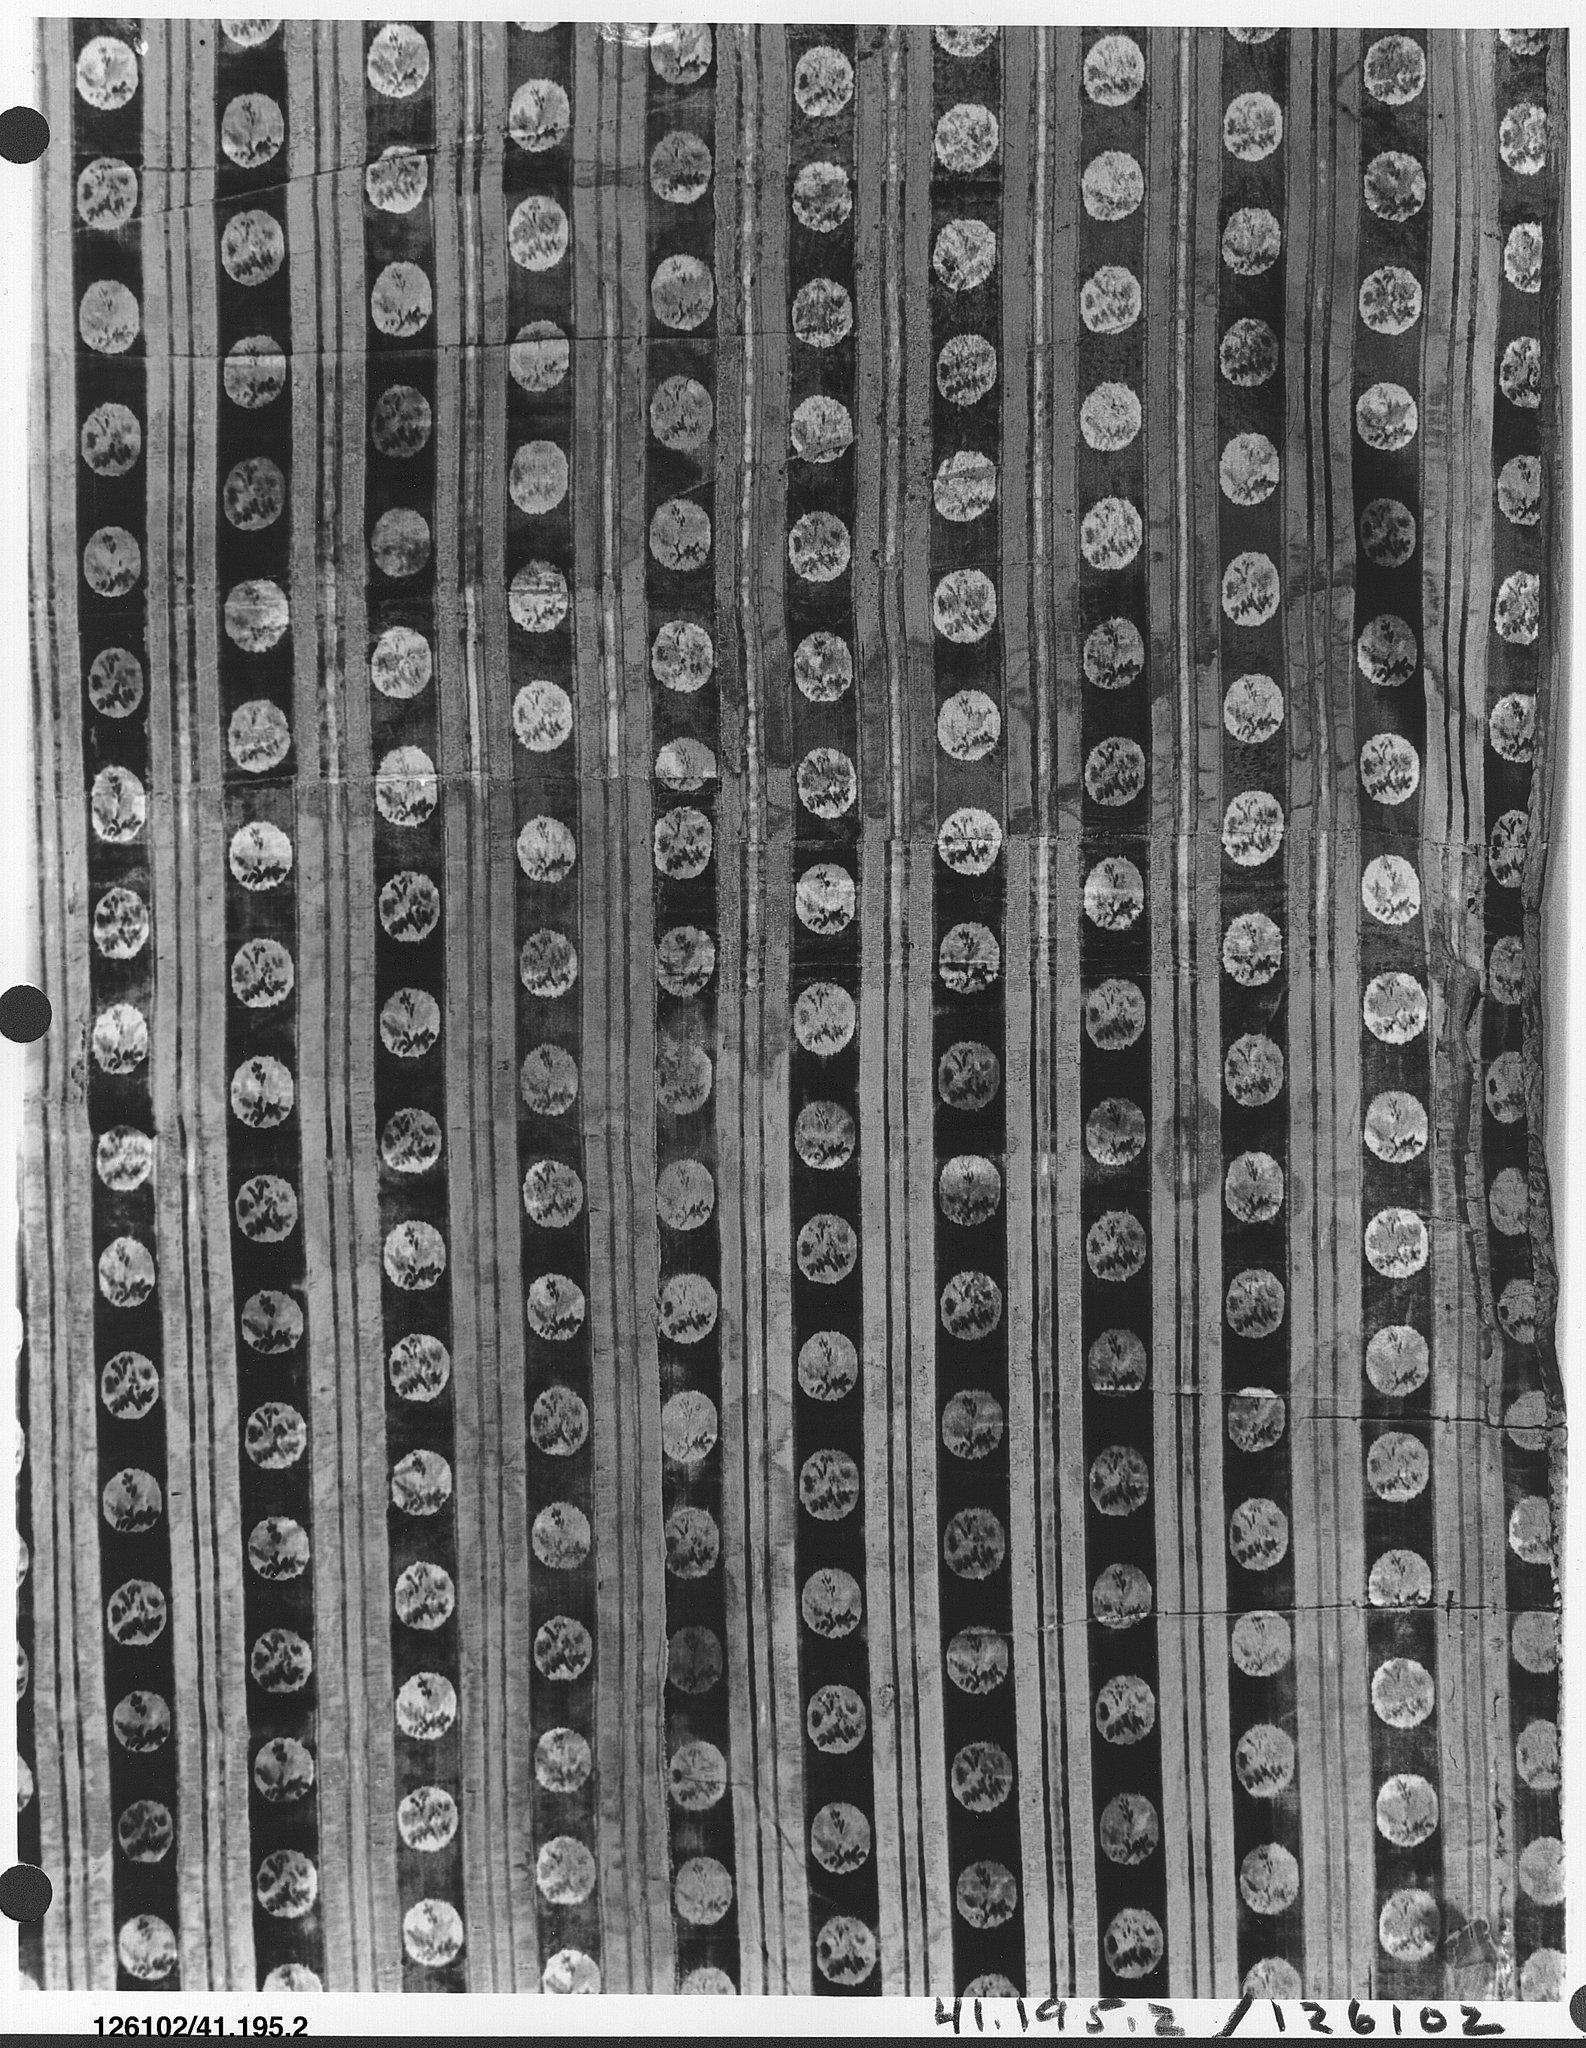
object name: piece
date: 1801-1833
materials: metal thread, silk